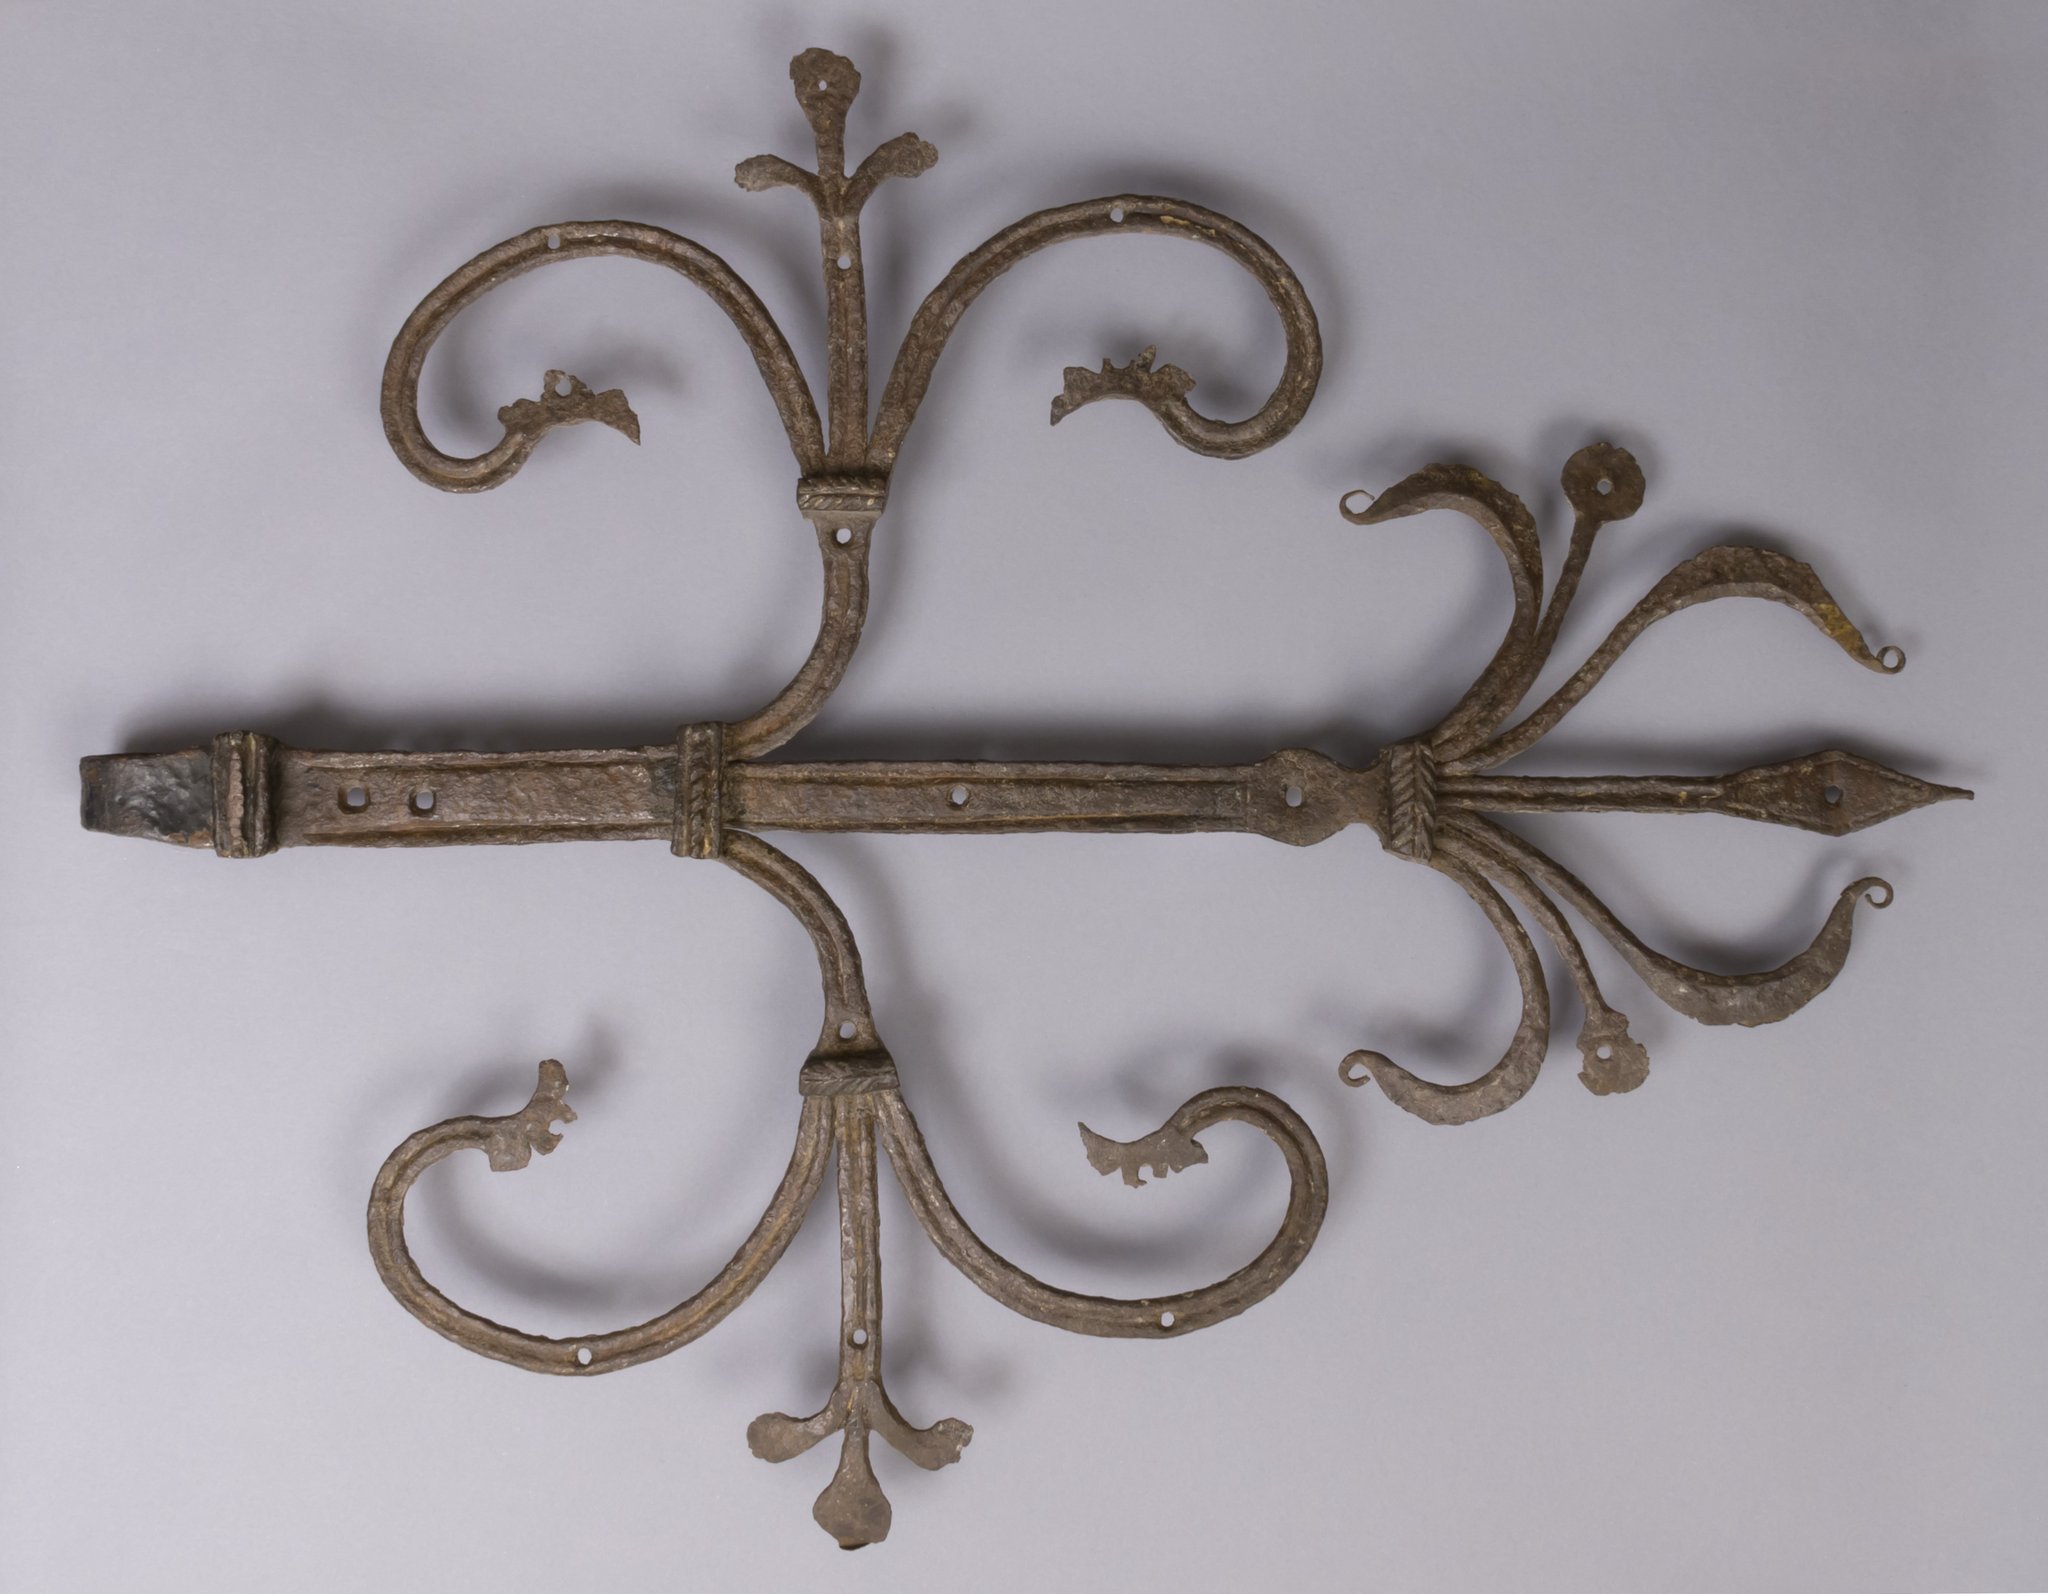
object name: hinge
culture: european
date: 1401-1600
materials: iron